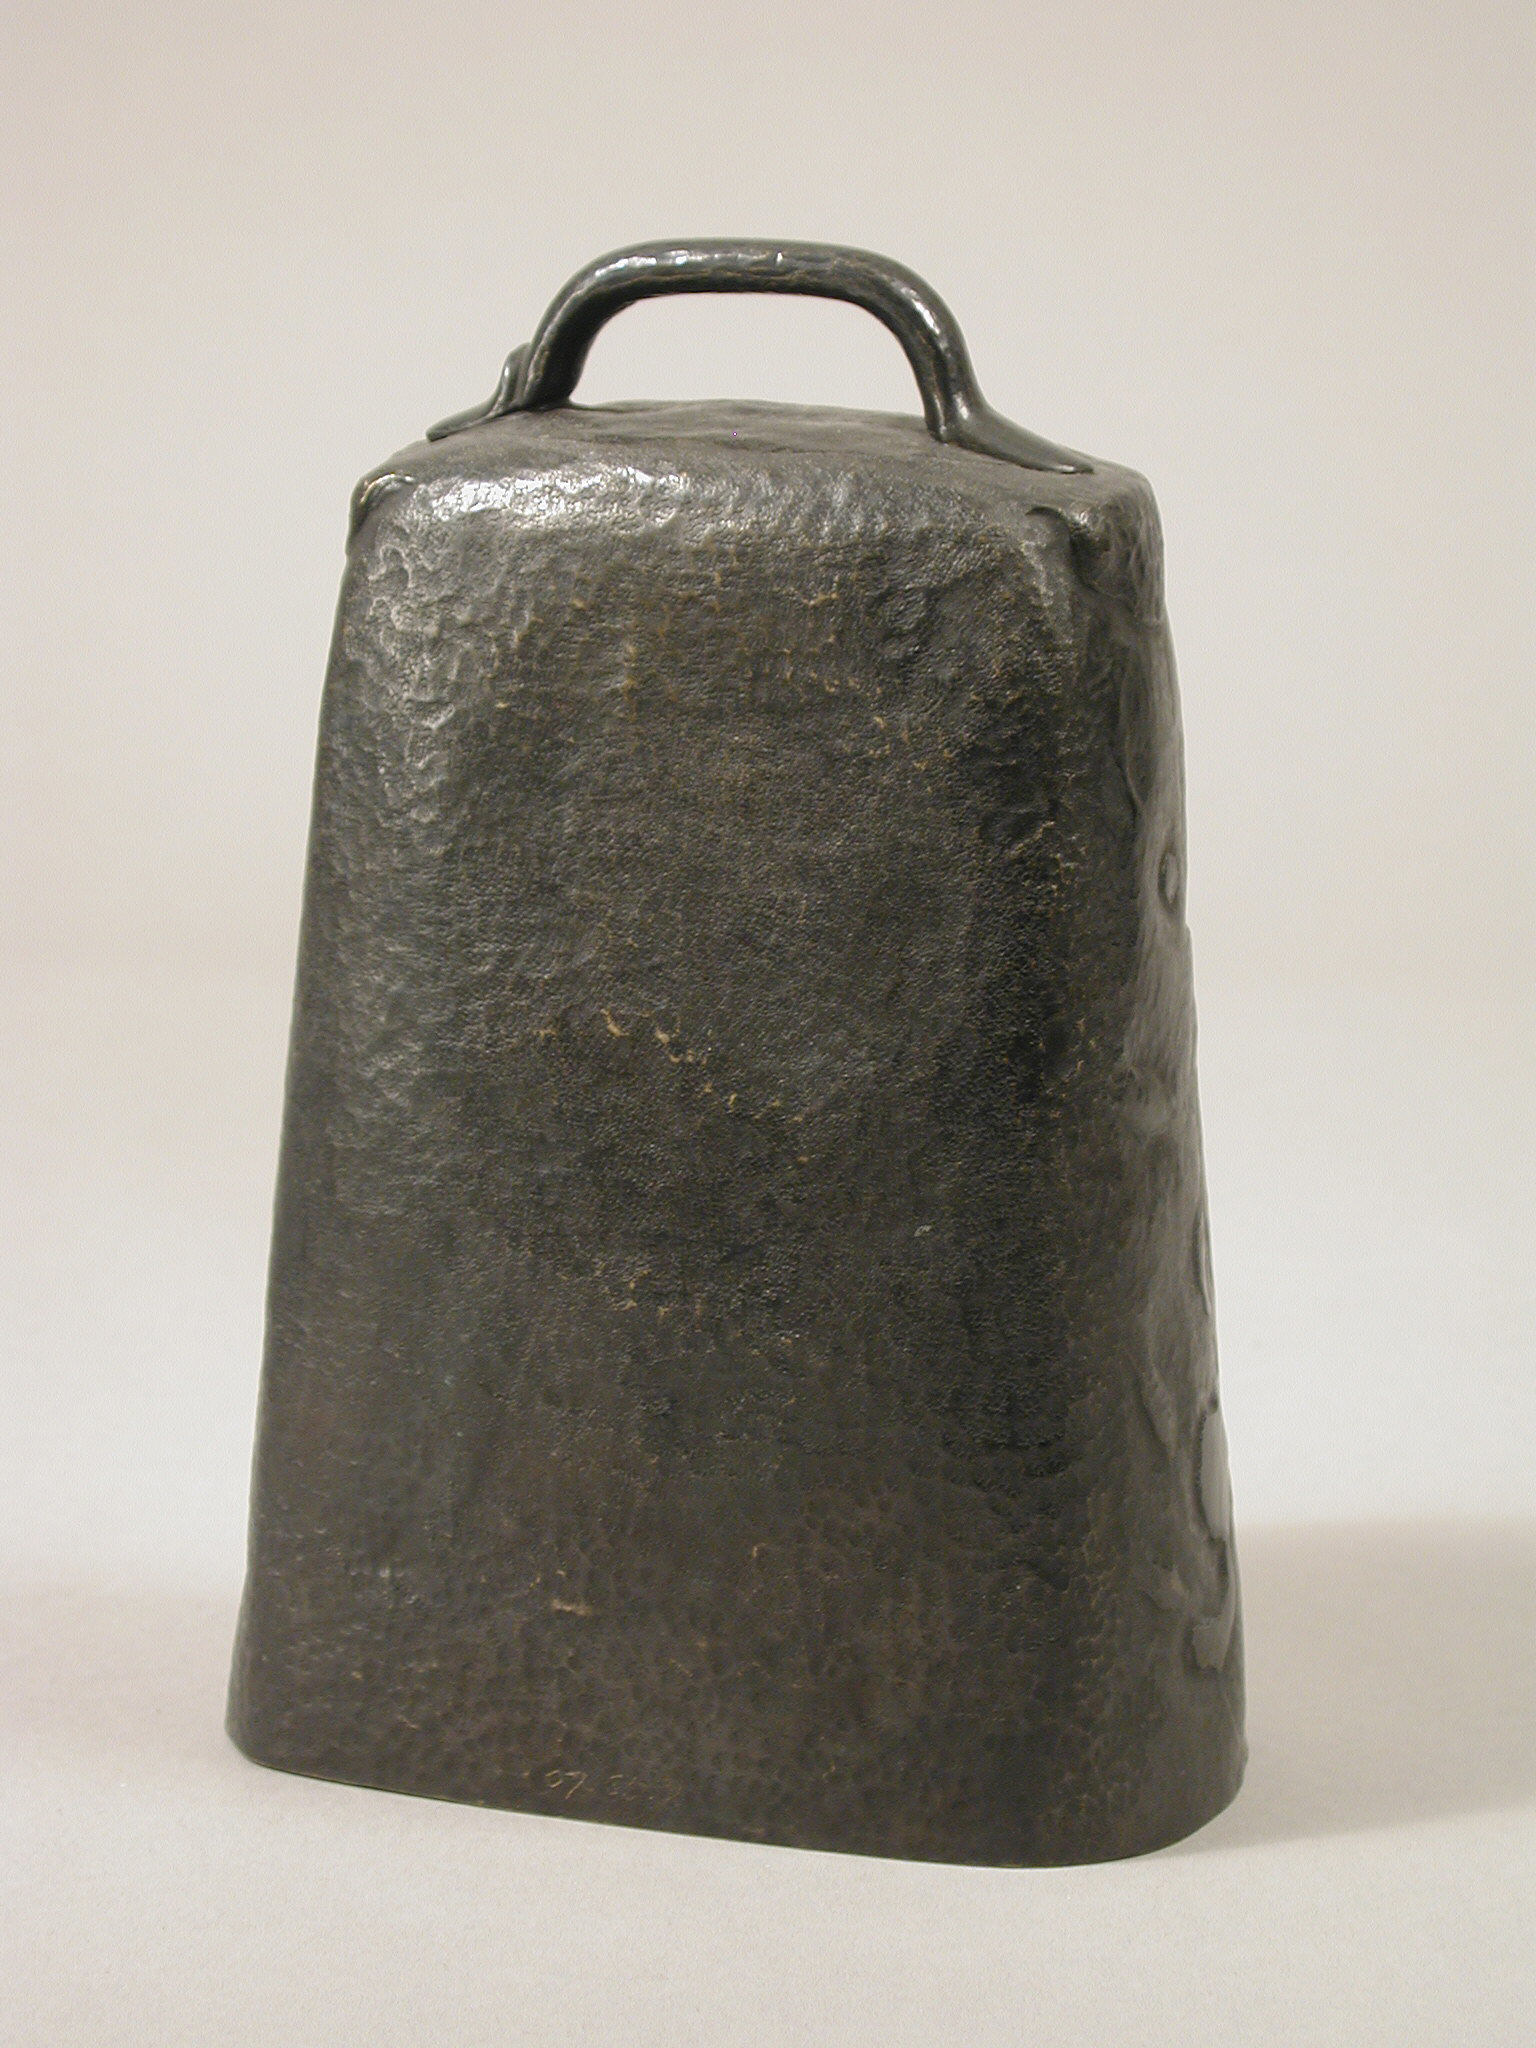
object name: bell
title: Bell of Saint Patrick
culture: irish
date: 1901-1933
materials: iron